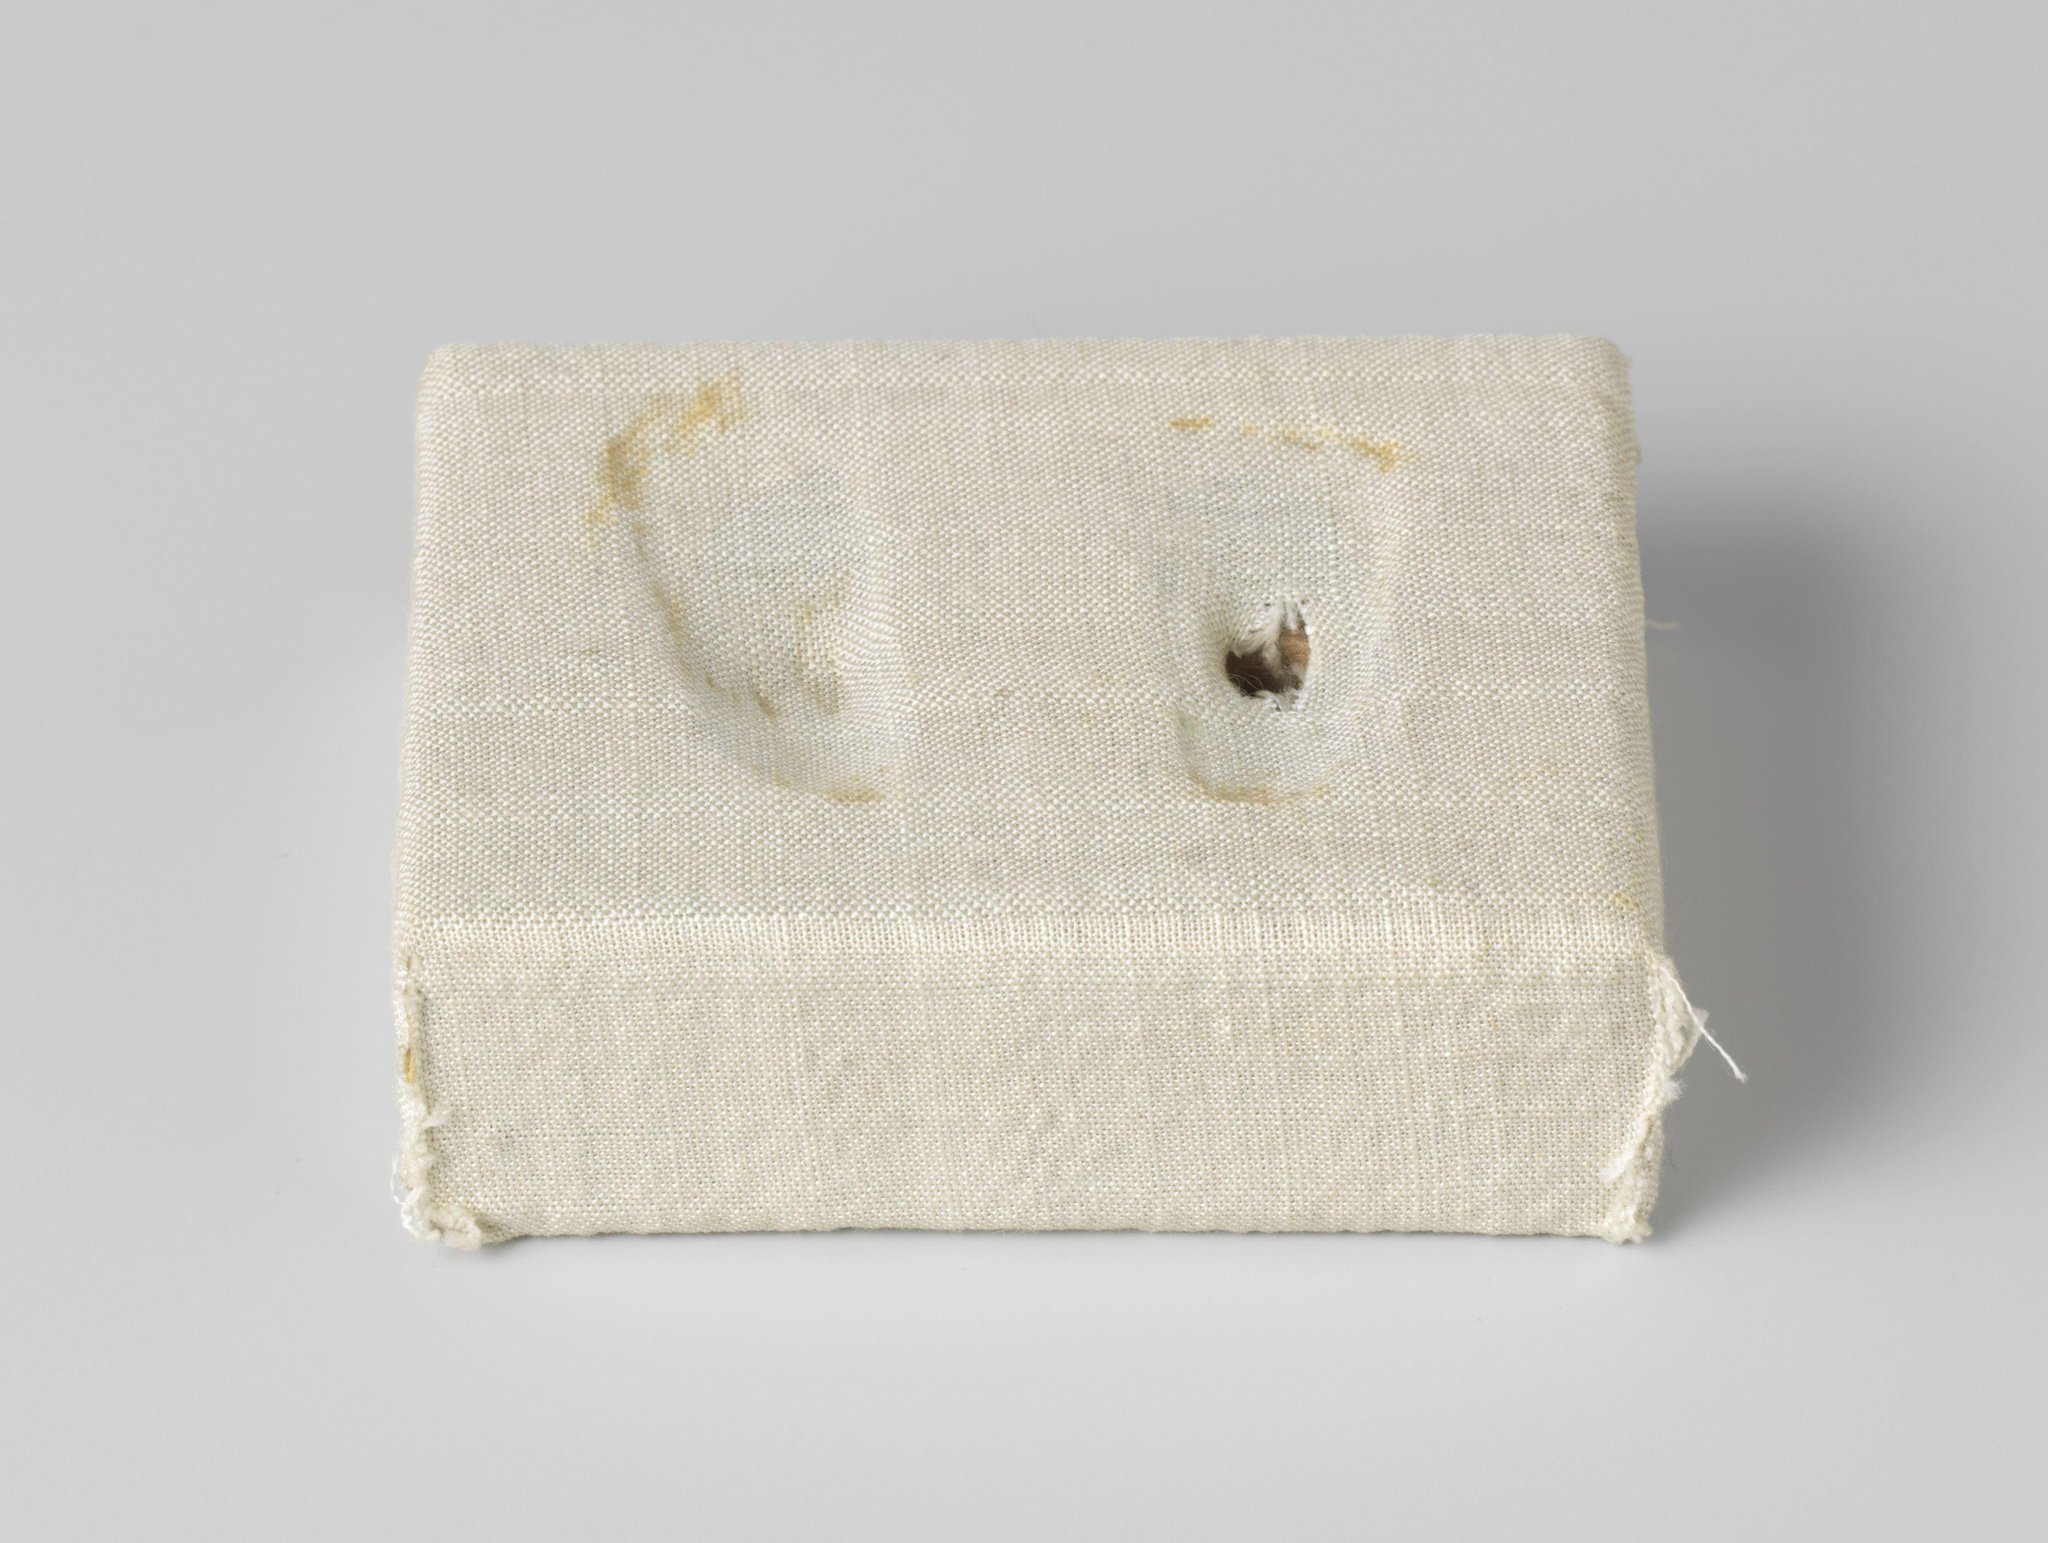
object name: steun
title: Steun van Tara of een godin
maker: Anonymous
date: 1800-2000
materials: textile, wood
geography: nepal